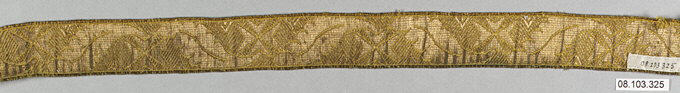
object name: galloon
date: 1801-1833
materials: metal thread, silk